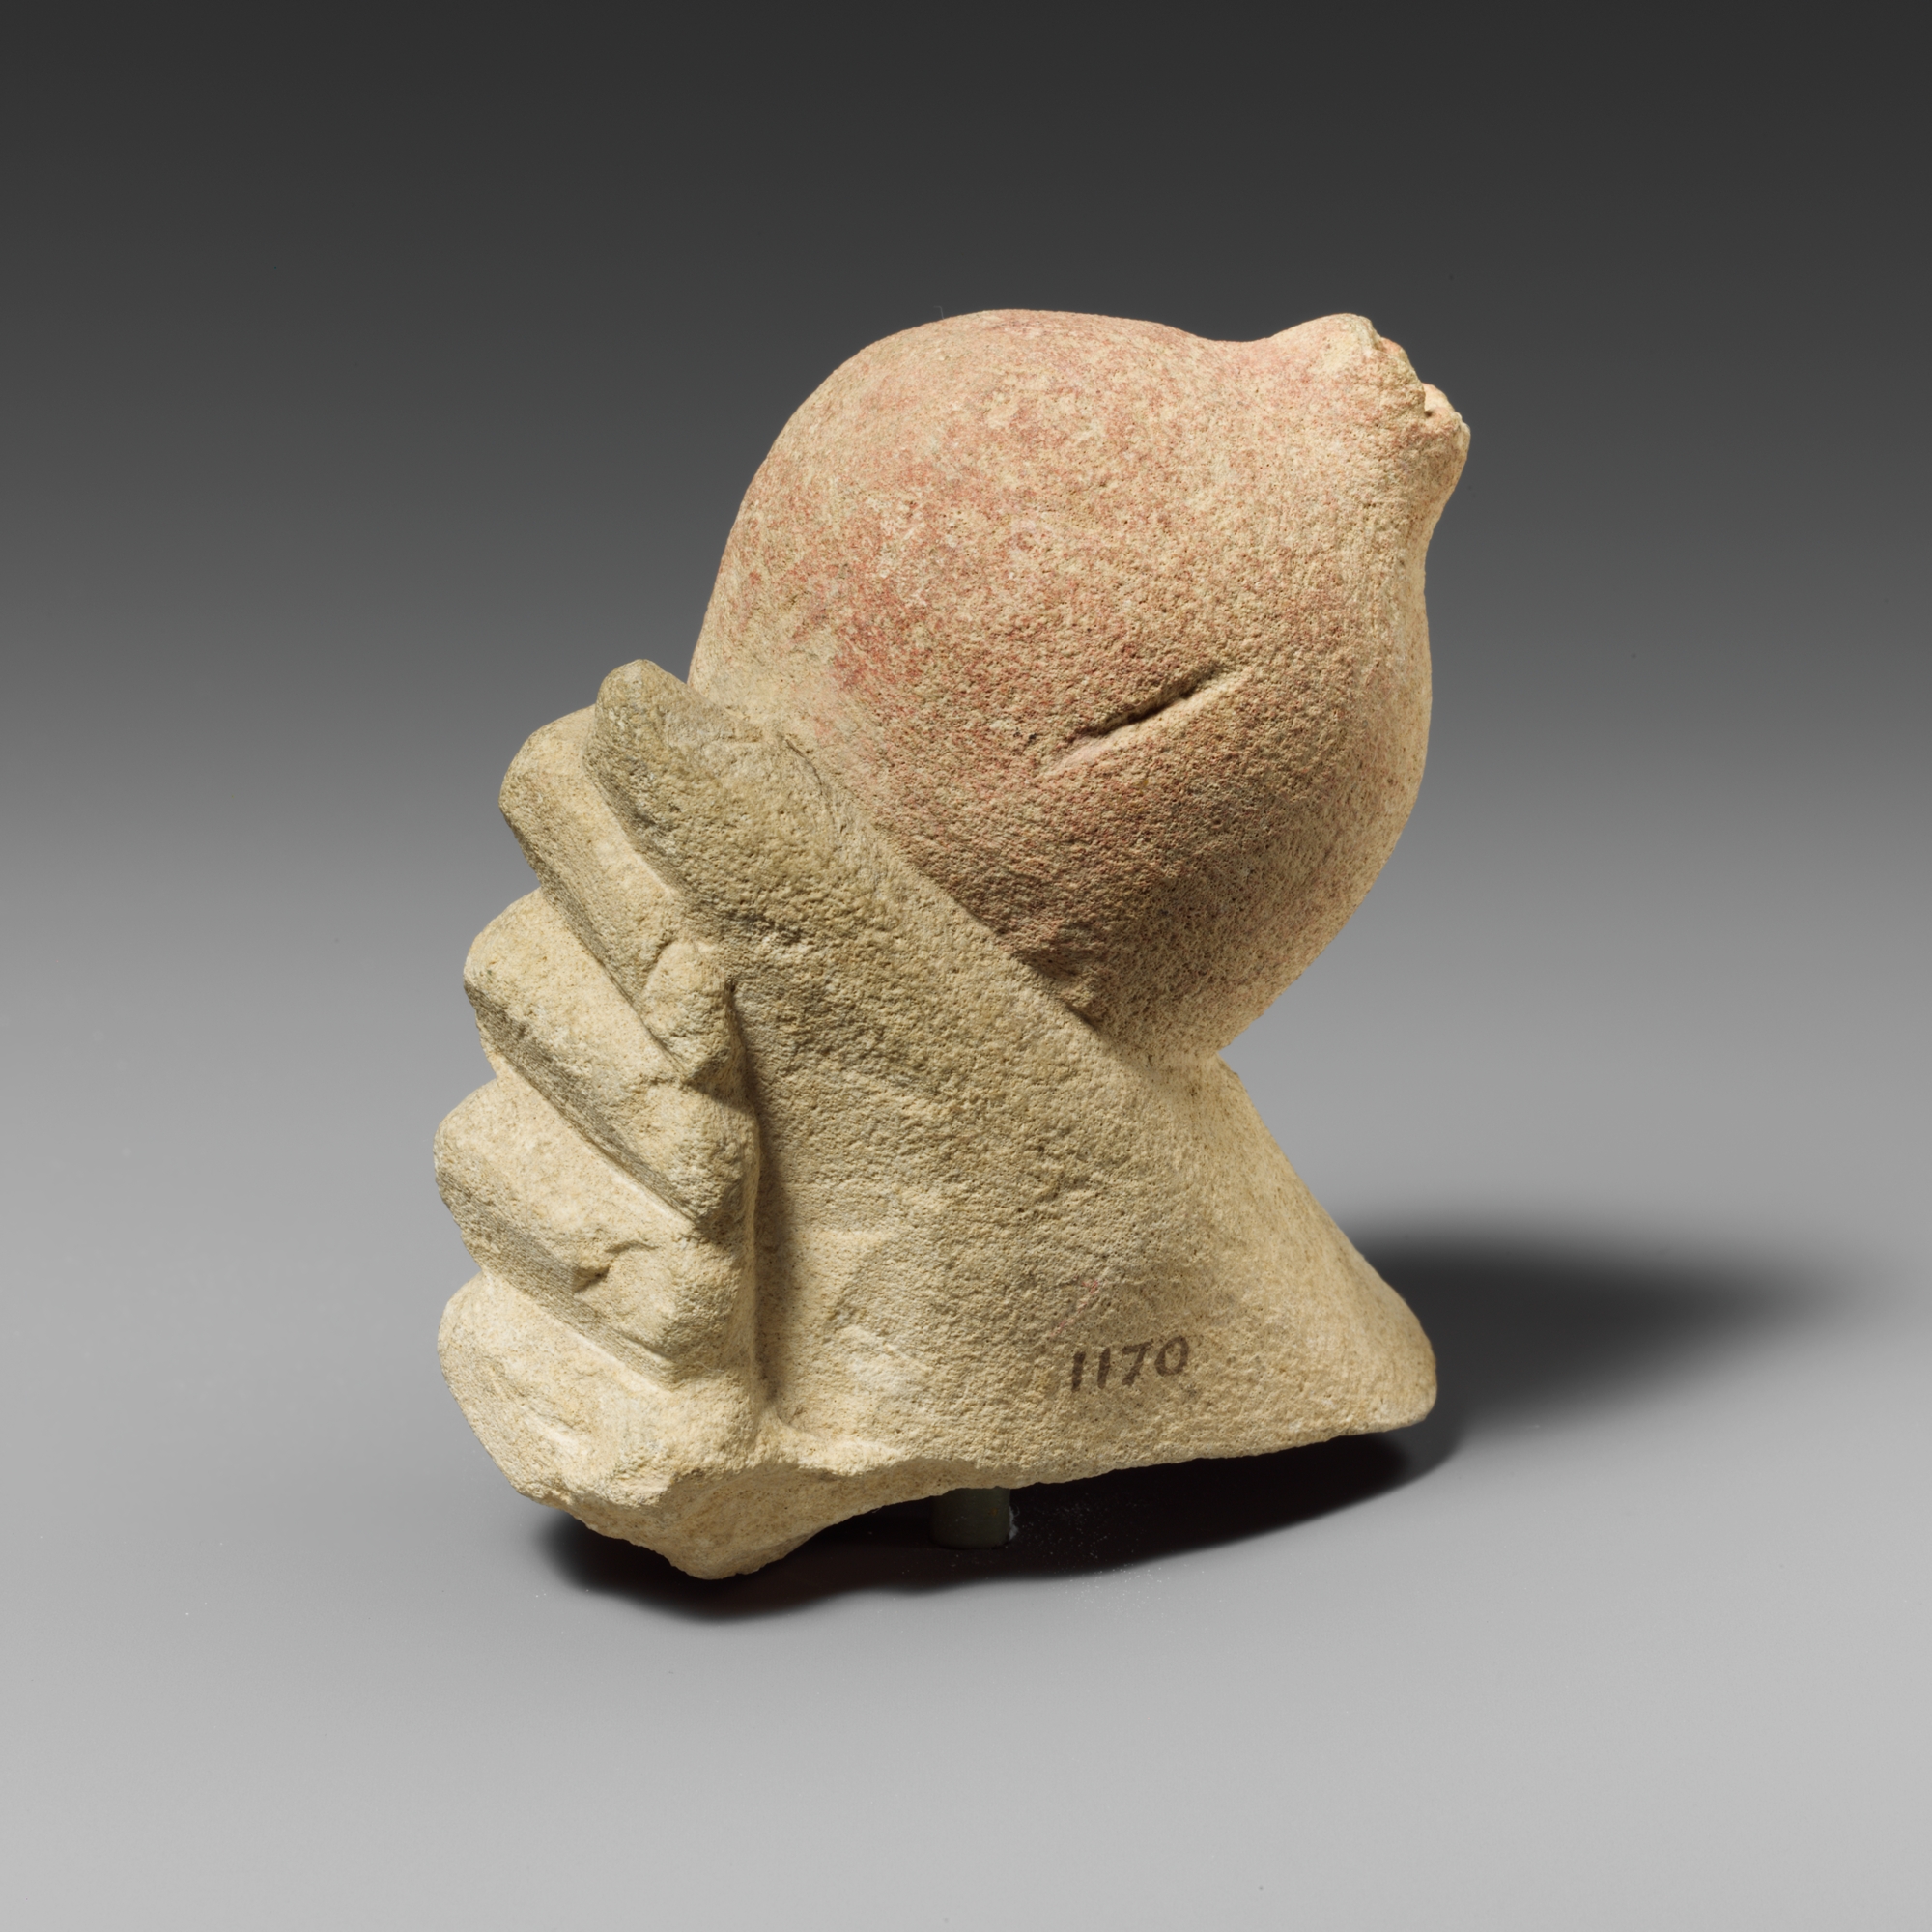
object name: hand, right, holding pomegranate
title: Limestone hand holding a pomegranate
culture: cypriot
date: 3900 BCE-100 CE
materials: limestone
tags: pomegranates,hands